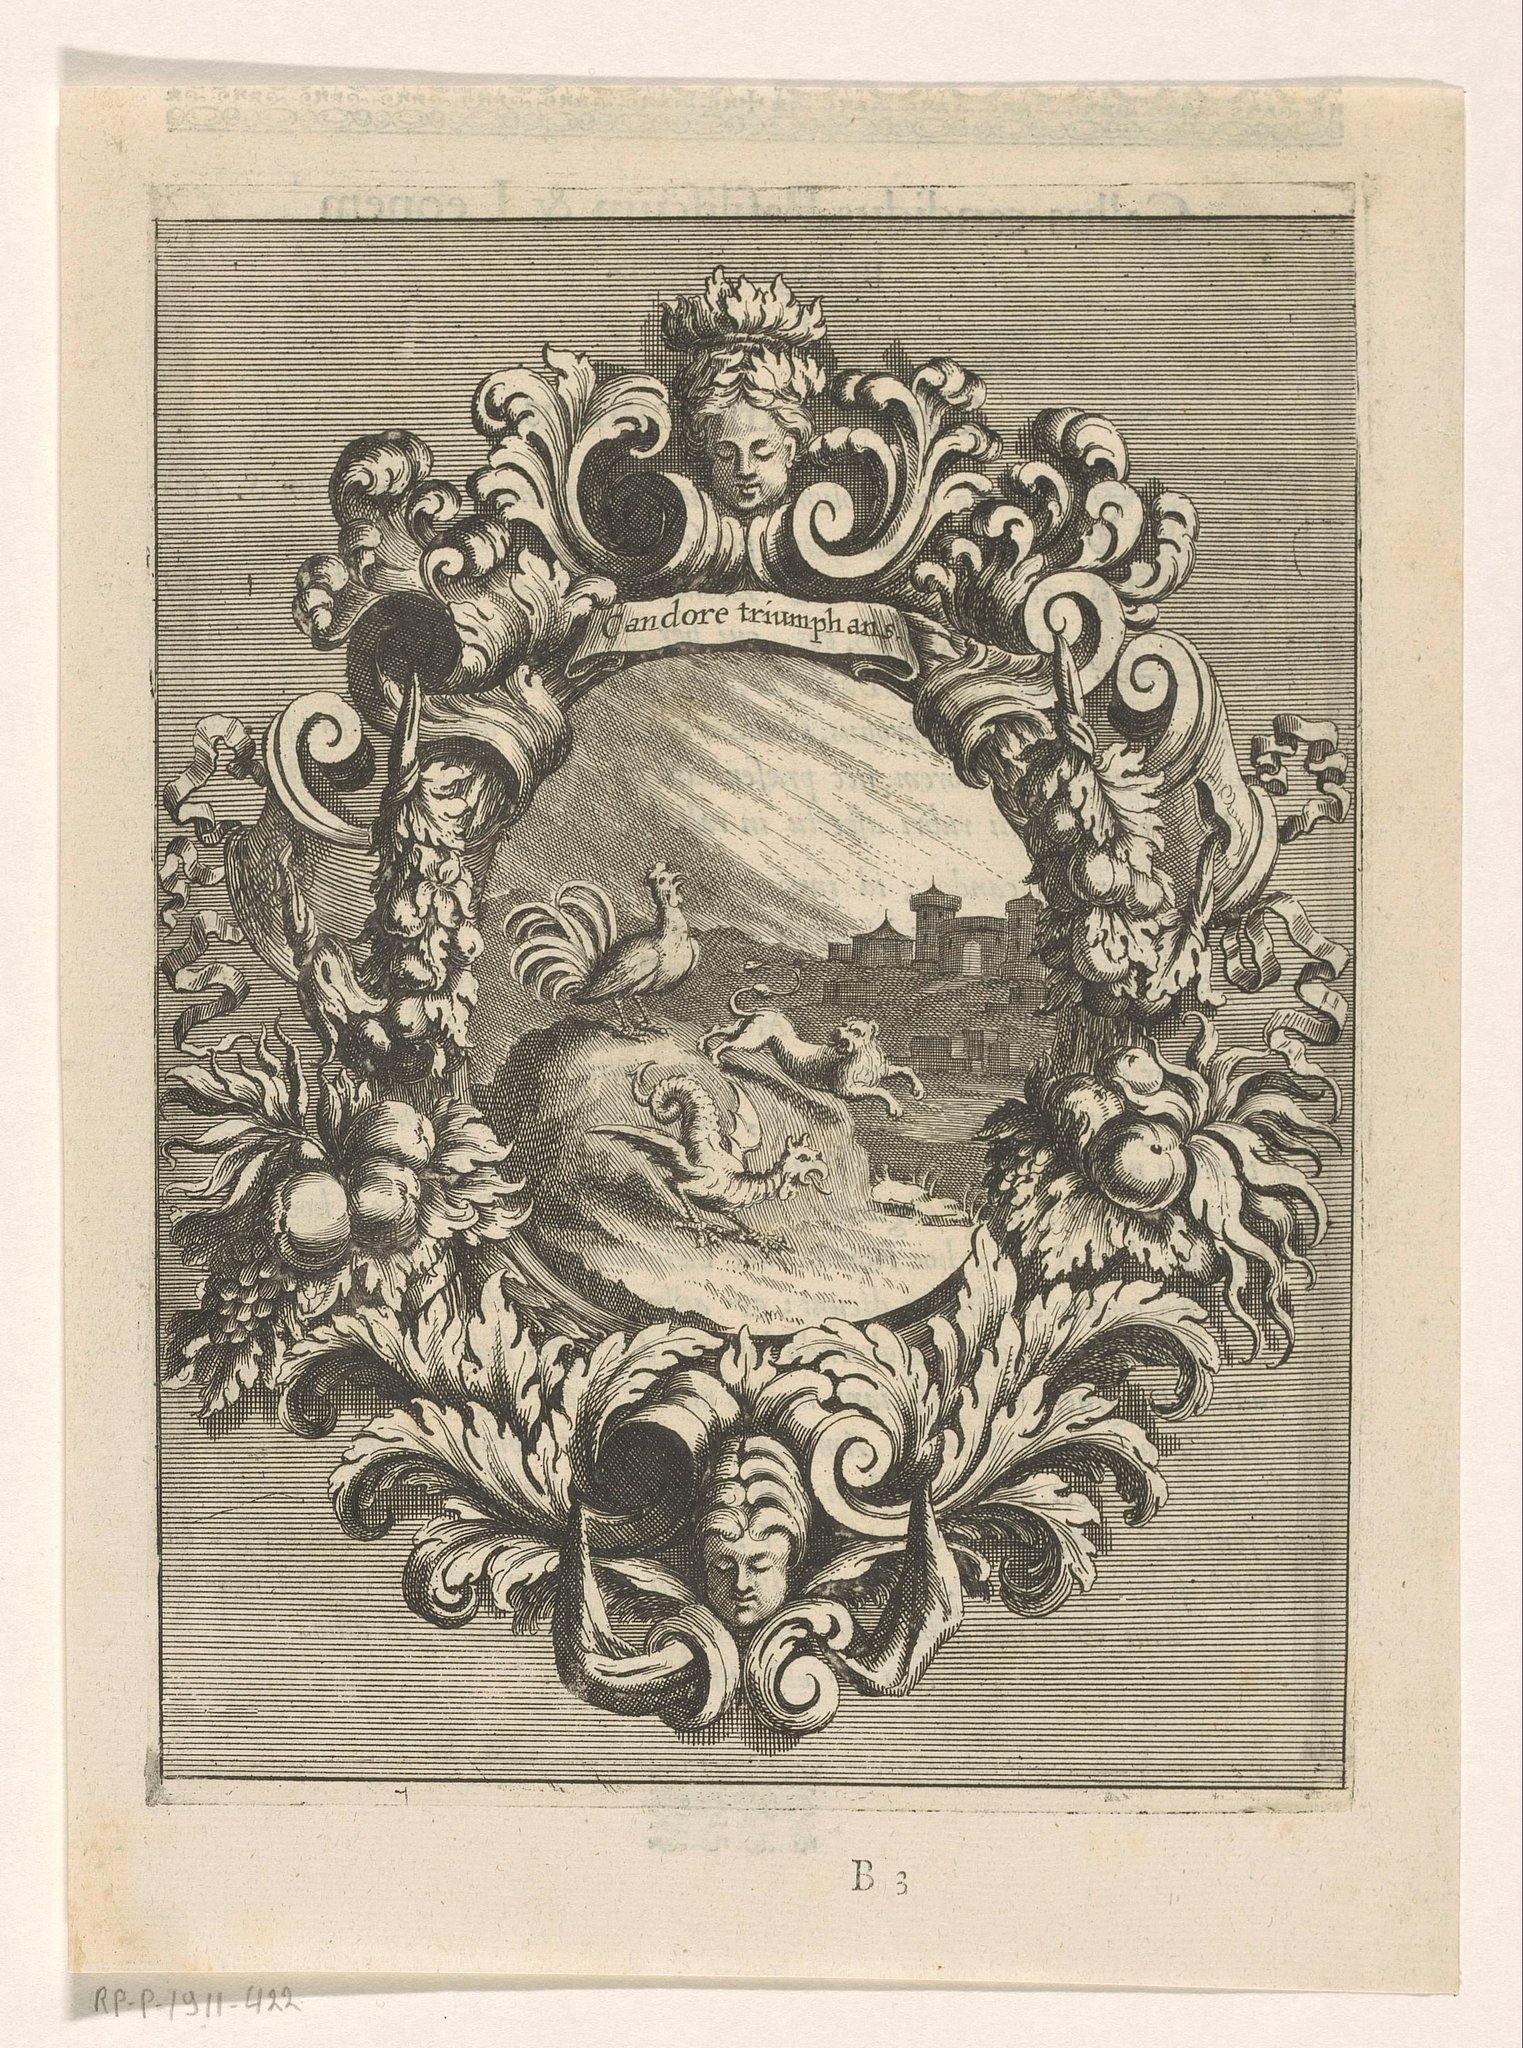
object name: print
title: Candora triumphans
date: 1695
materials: paper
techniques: etching, letterpress printing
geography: sankt gallen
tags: fowl (cock, hen, chicken, etc.), abstract ideas and concepts (+ emblematical representation of concept), basilisk (cock with posterior of snake), 'manticora'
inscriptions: collector's mark: Lugt 2228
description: Cartouche met embleem. Het embleem toont een haan, die al kraaiend op een heuvel staat. Naast de heuvel lopen een leeuw en een basilisk, twee fabeldieren die volgens legende stierven bij het horen van het gekraai van een haan. Op de achtergrond een stadsgezicht. Latijns motto op een banderol.